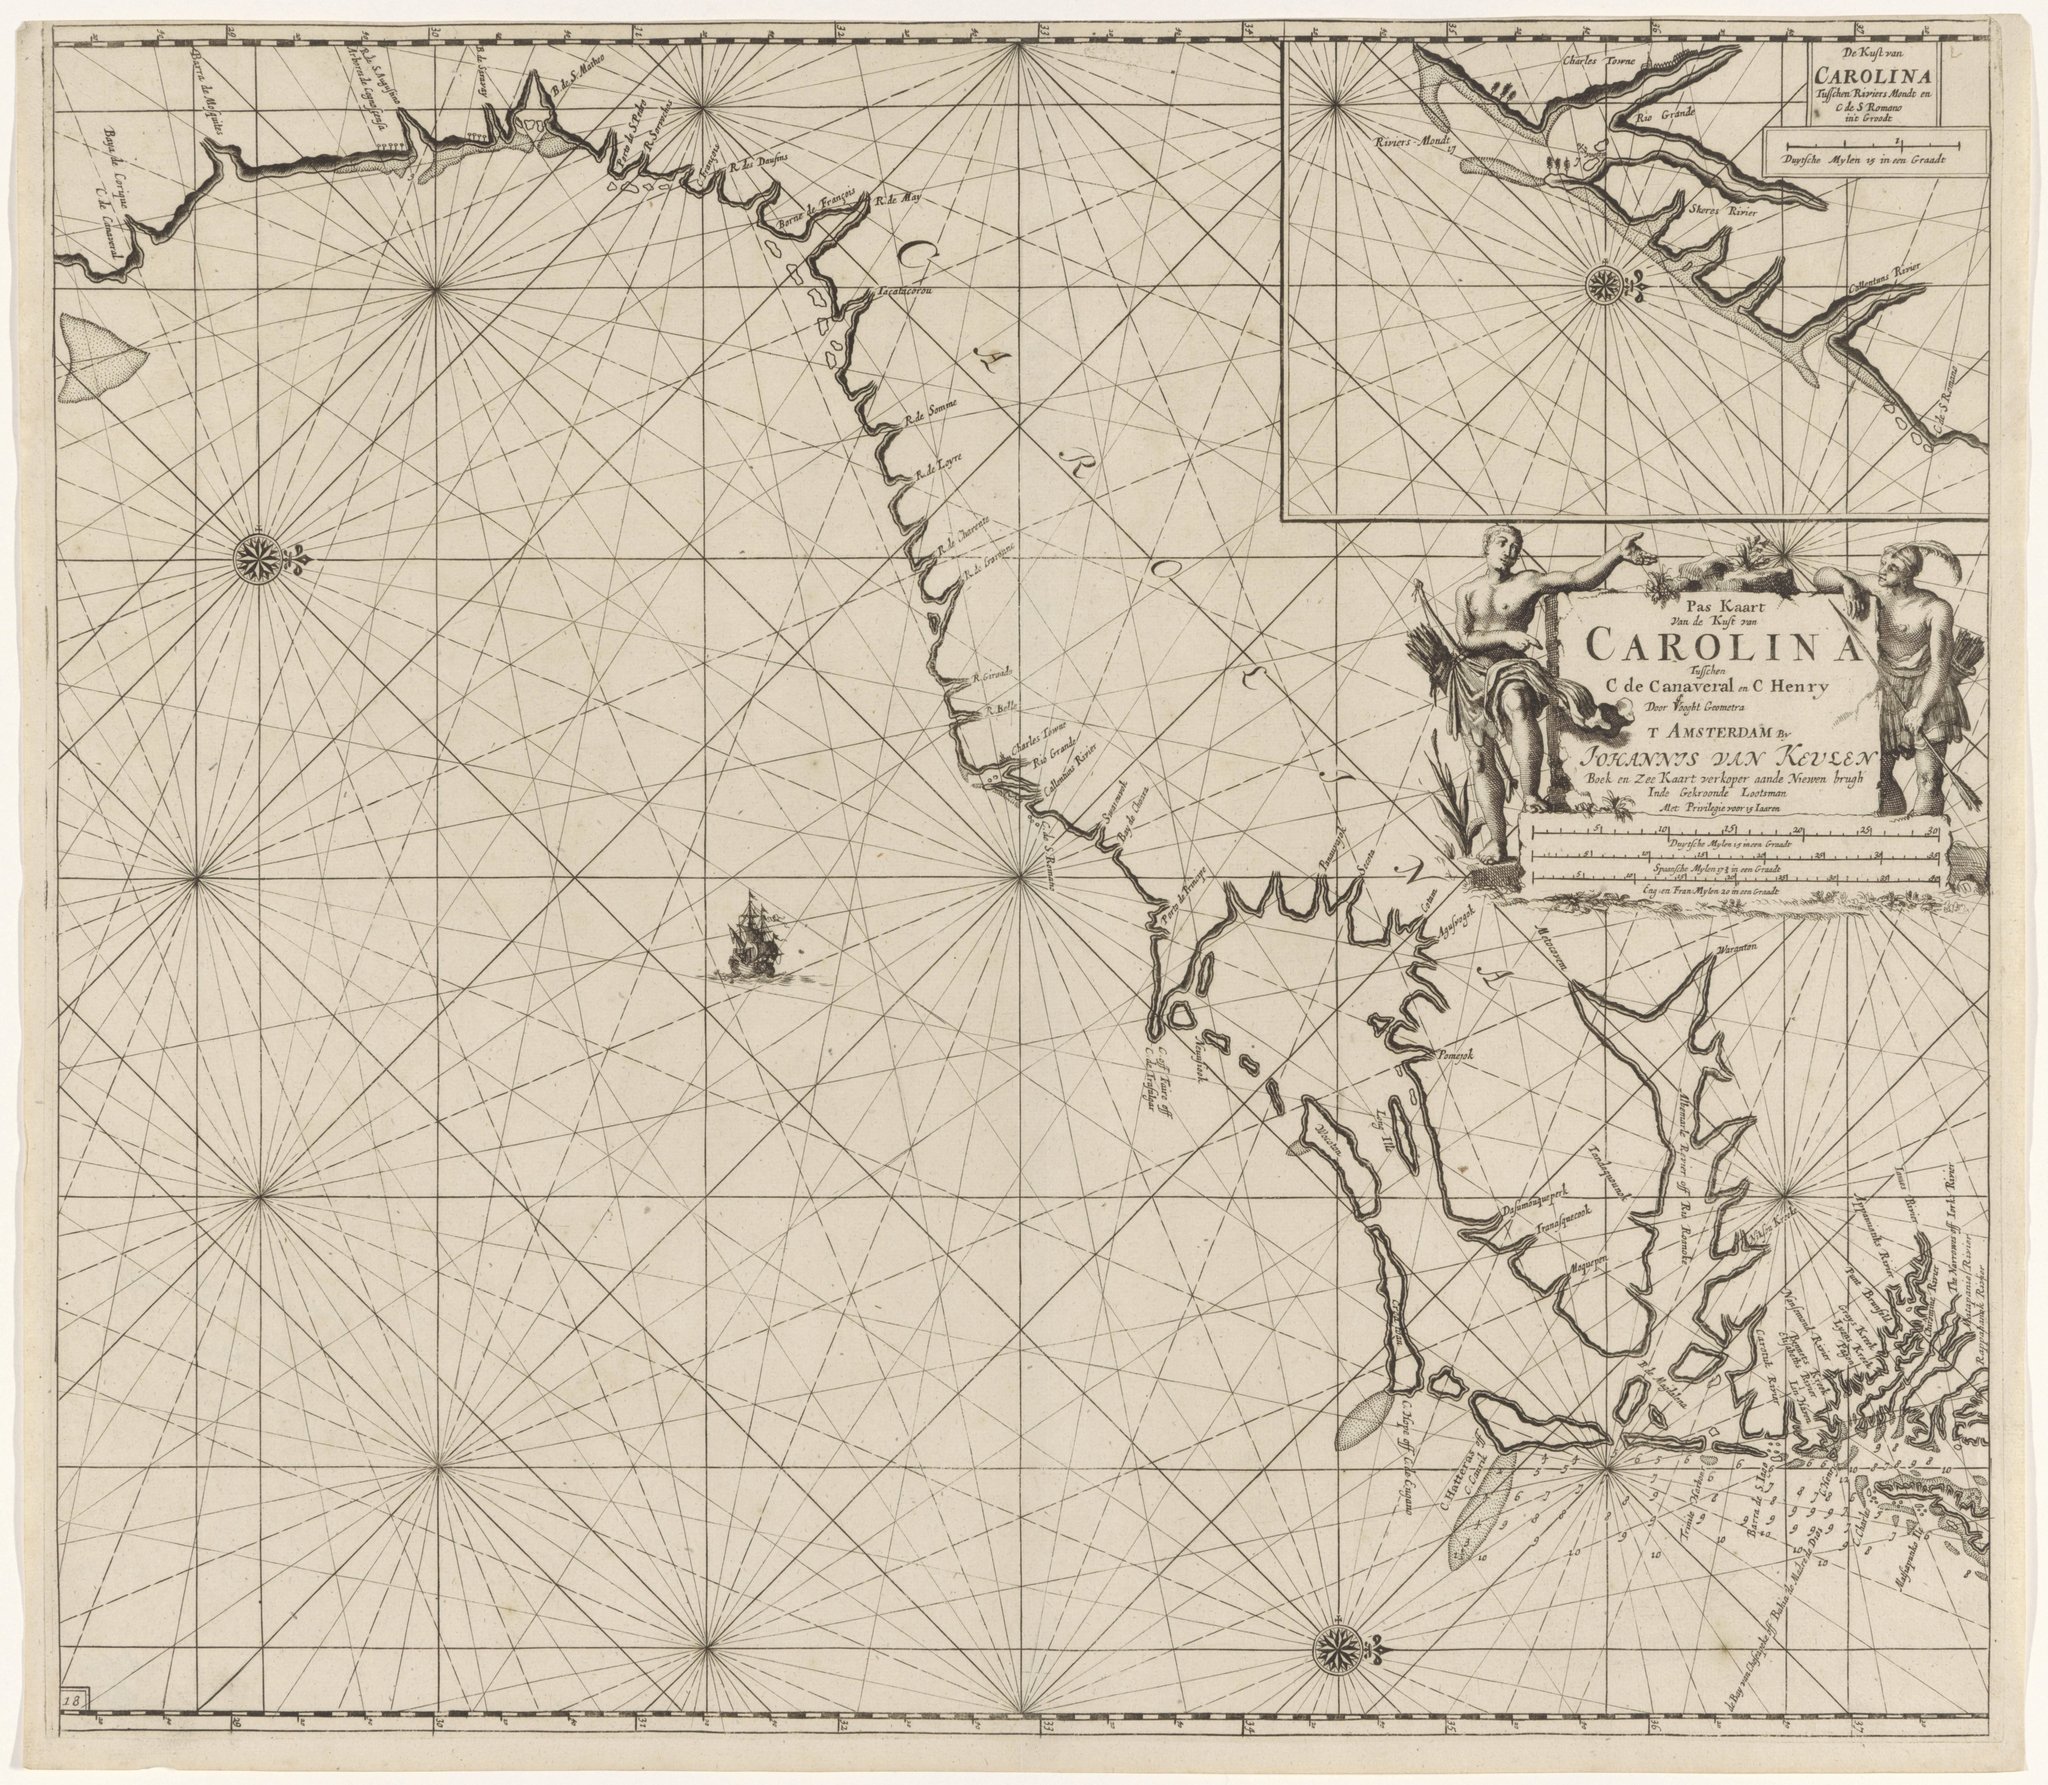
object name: print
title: Pas kaart van de kust van Carolina tusschen C. de Canaveral en C. Henry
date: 1684-1799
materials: paper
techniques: engraving, etching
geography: amsterdam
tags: sailing-ship, sailing-boat, archer's weapons: bow and arrow, indigenous peoples of north america, united states of america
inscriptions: collector's mark: Lugt 2228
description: Paskaart van een deel van de oostkust van de Verenigde Staten, vanaf Kaap Canaveral tot Kaap Hateras, met een inzetkaart van Georgetown. De kaart bevat twee kompasrozen, het Noorden ligt rechts. Rechtsmidden de titel, het uitgeversadres en de schaalverdeling, weergegeven in Duitse, Spaanse en Engelse of Franse mijlen (schaal: c. 1:1.800.000). De gegevens zijn geflankeerd door twee mannen met pijl en boog.